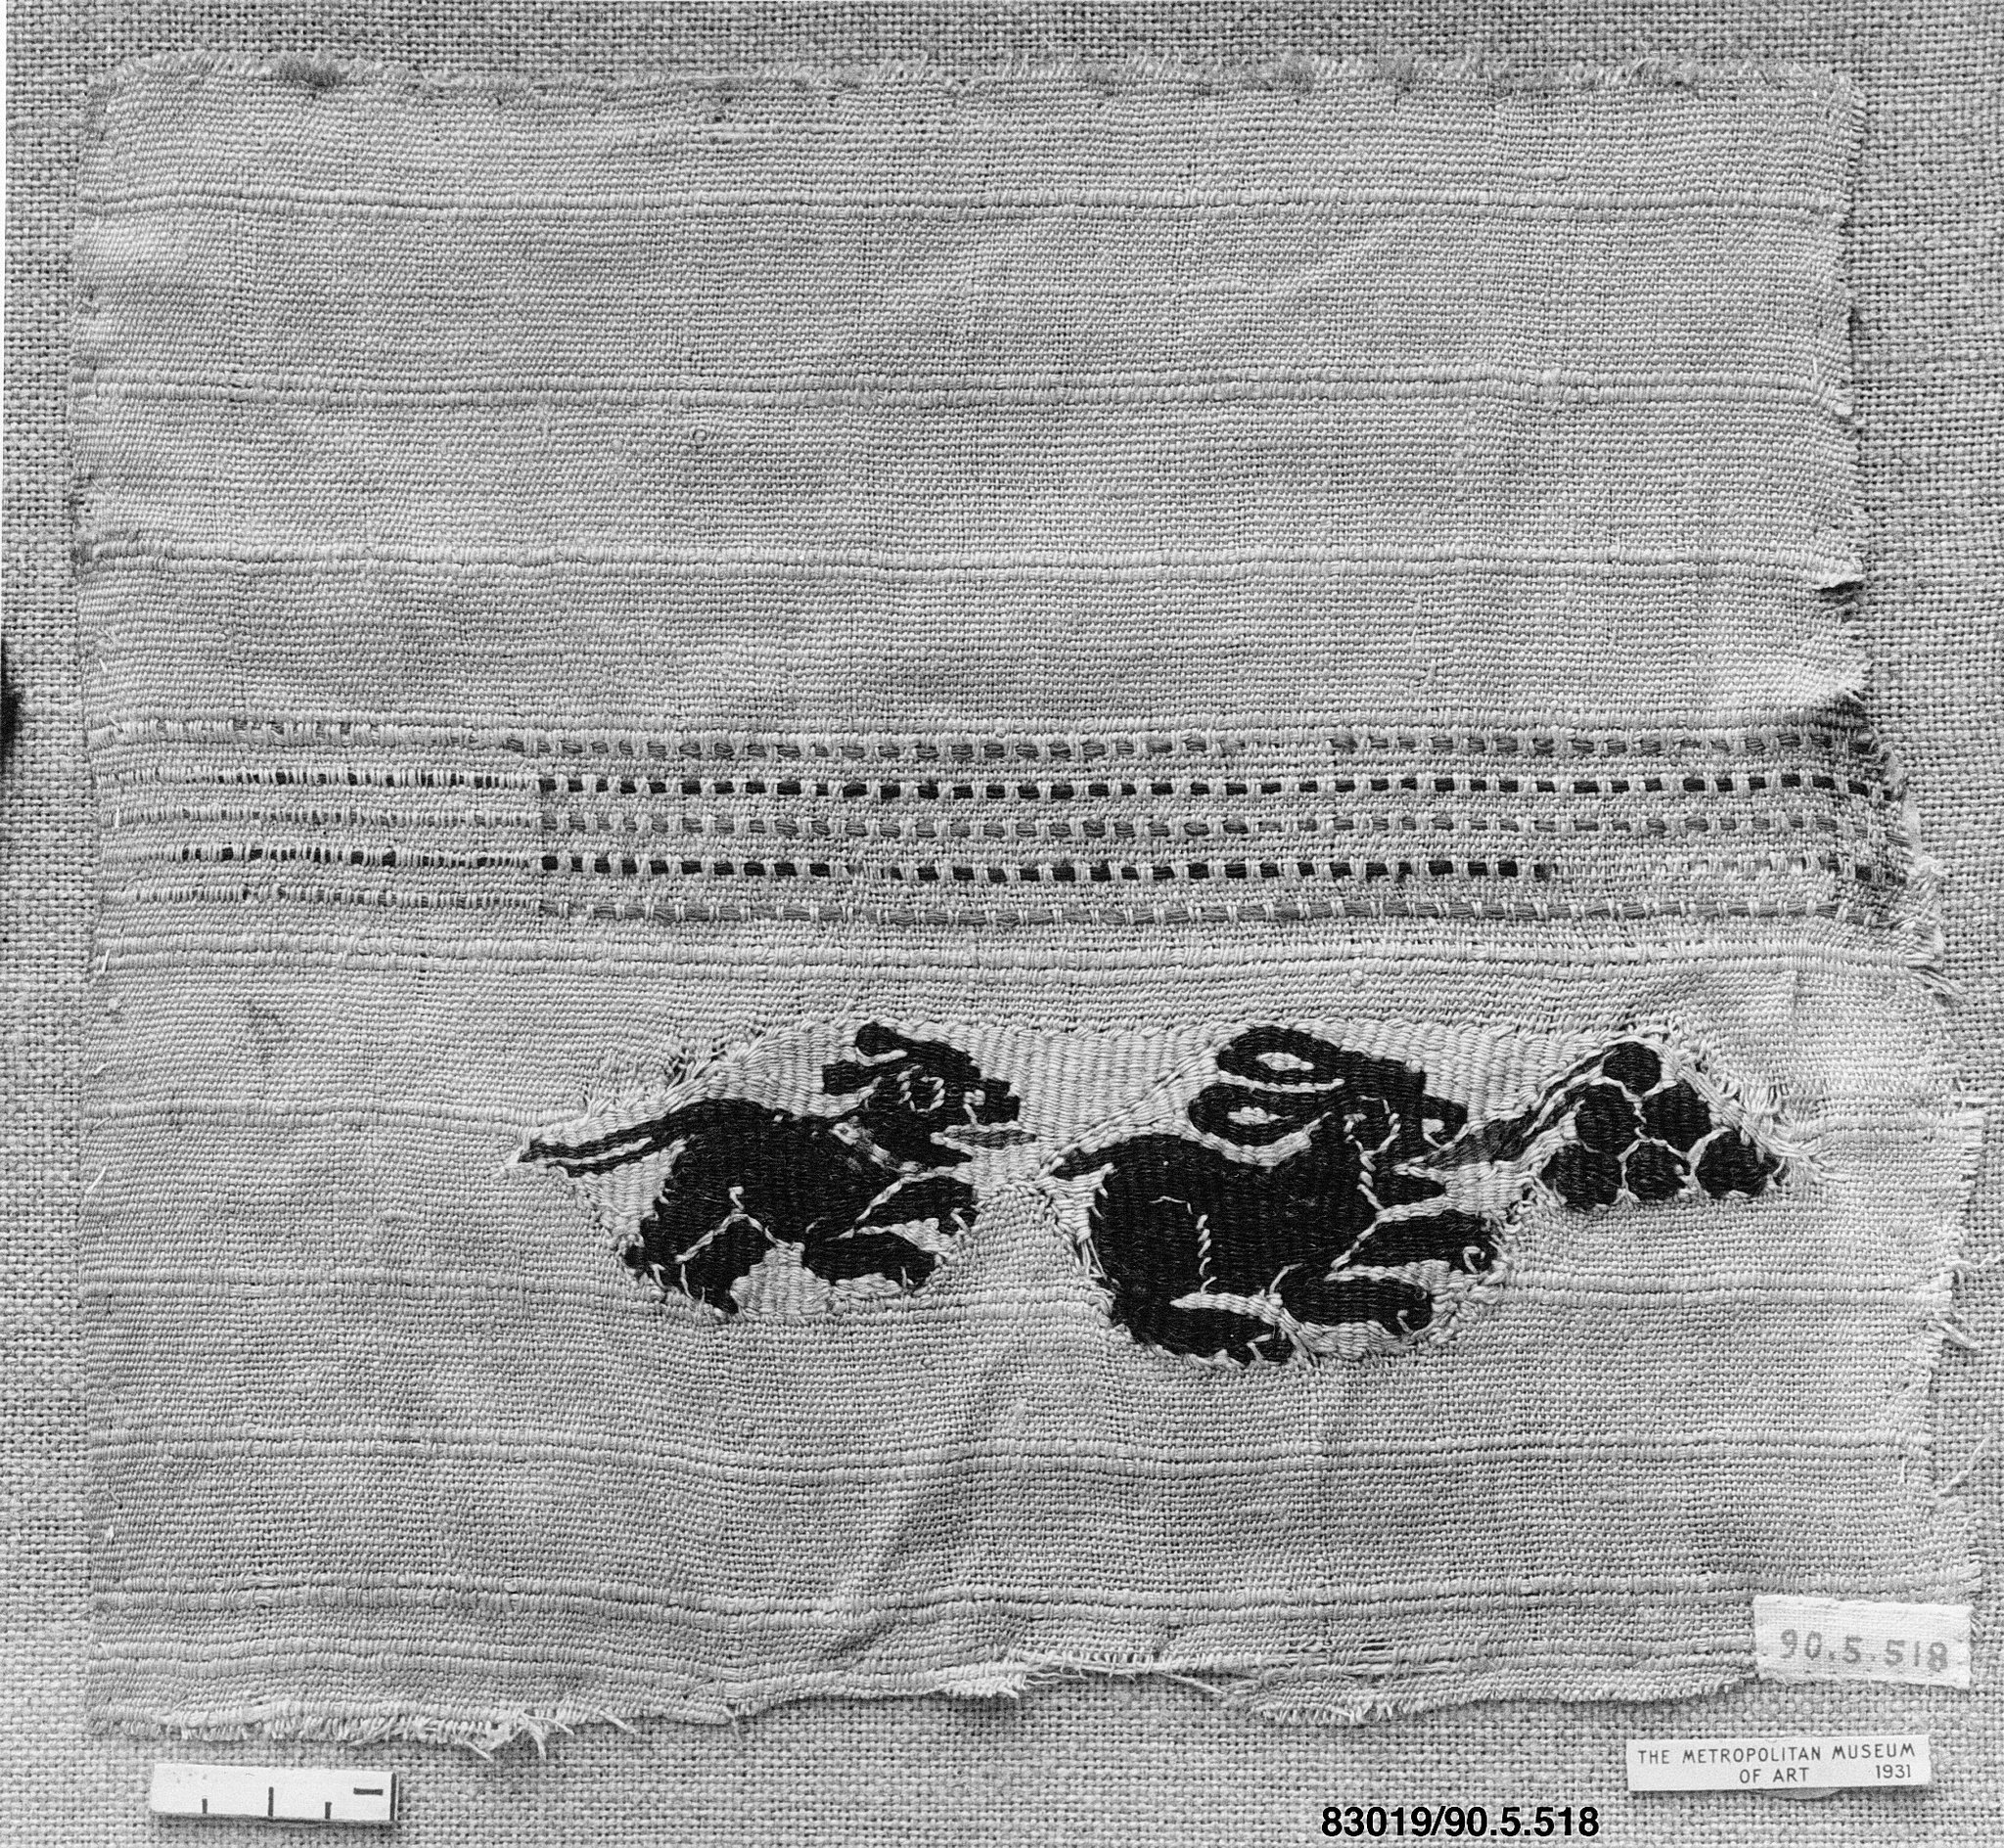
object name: textile fragment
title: Fragment with a Dog, Hare, and a Bunch of Grapes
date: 401-600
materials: linen, wool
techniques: weave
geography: egypt